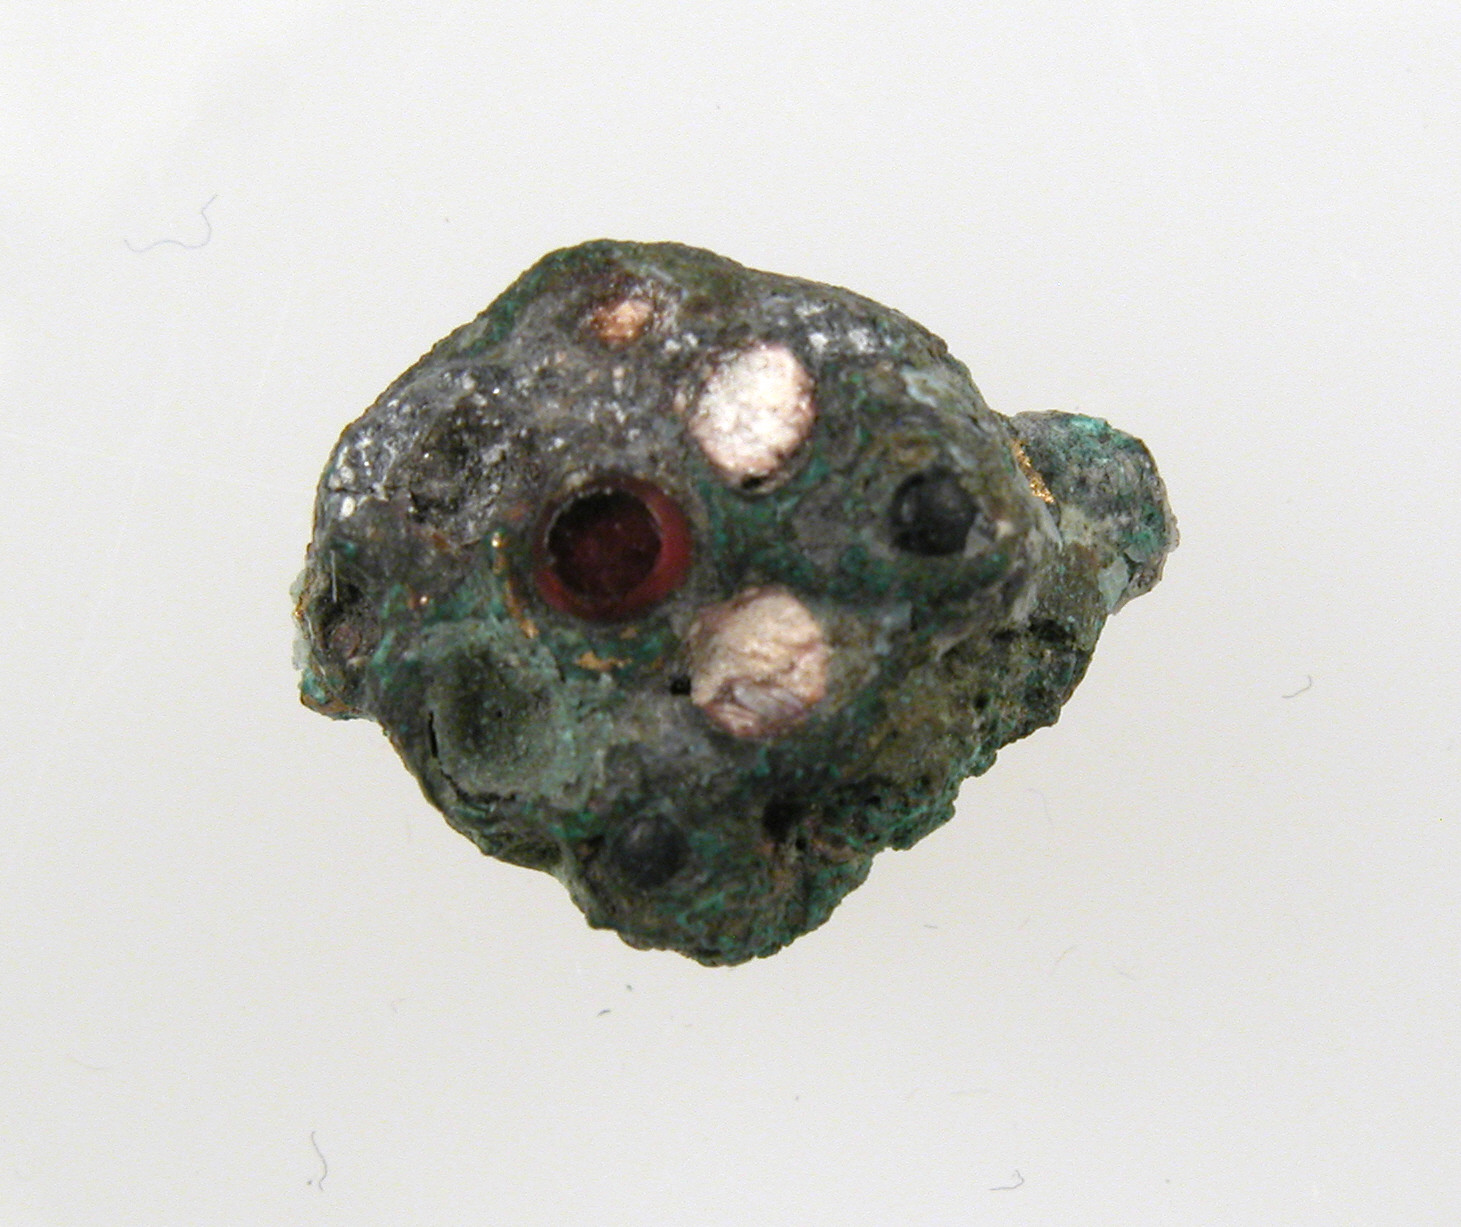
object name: ring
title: Finger Ring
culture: frankish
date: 501-700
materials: bone, copper alloy, gilt, glass, paste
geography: northern france